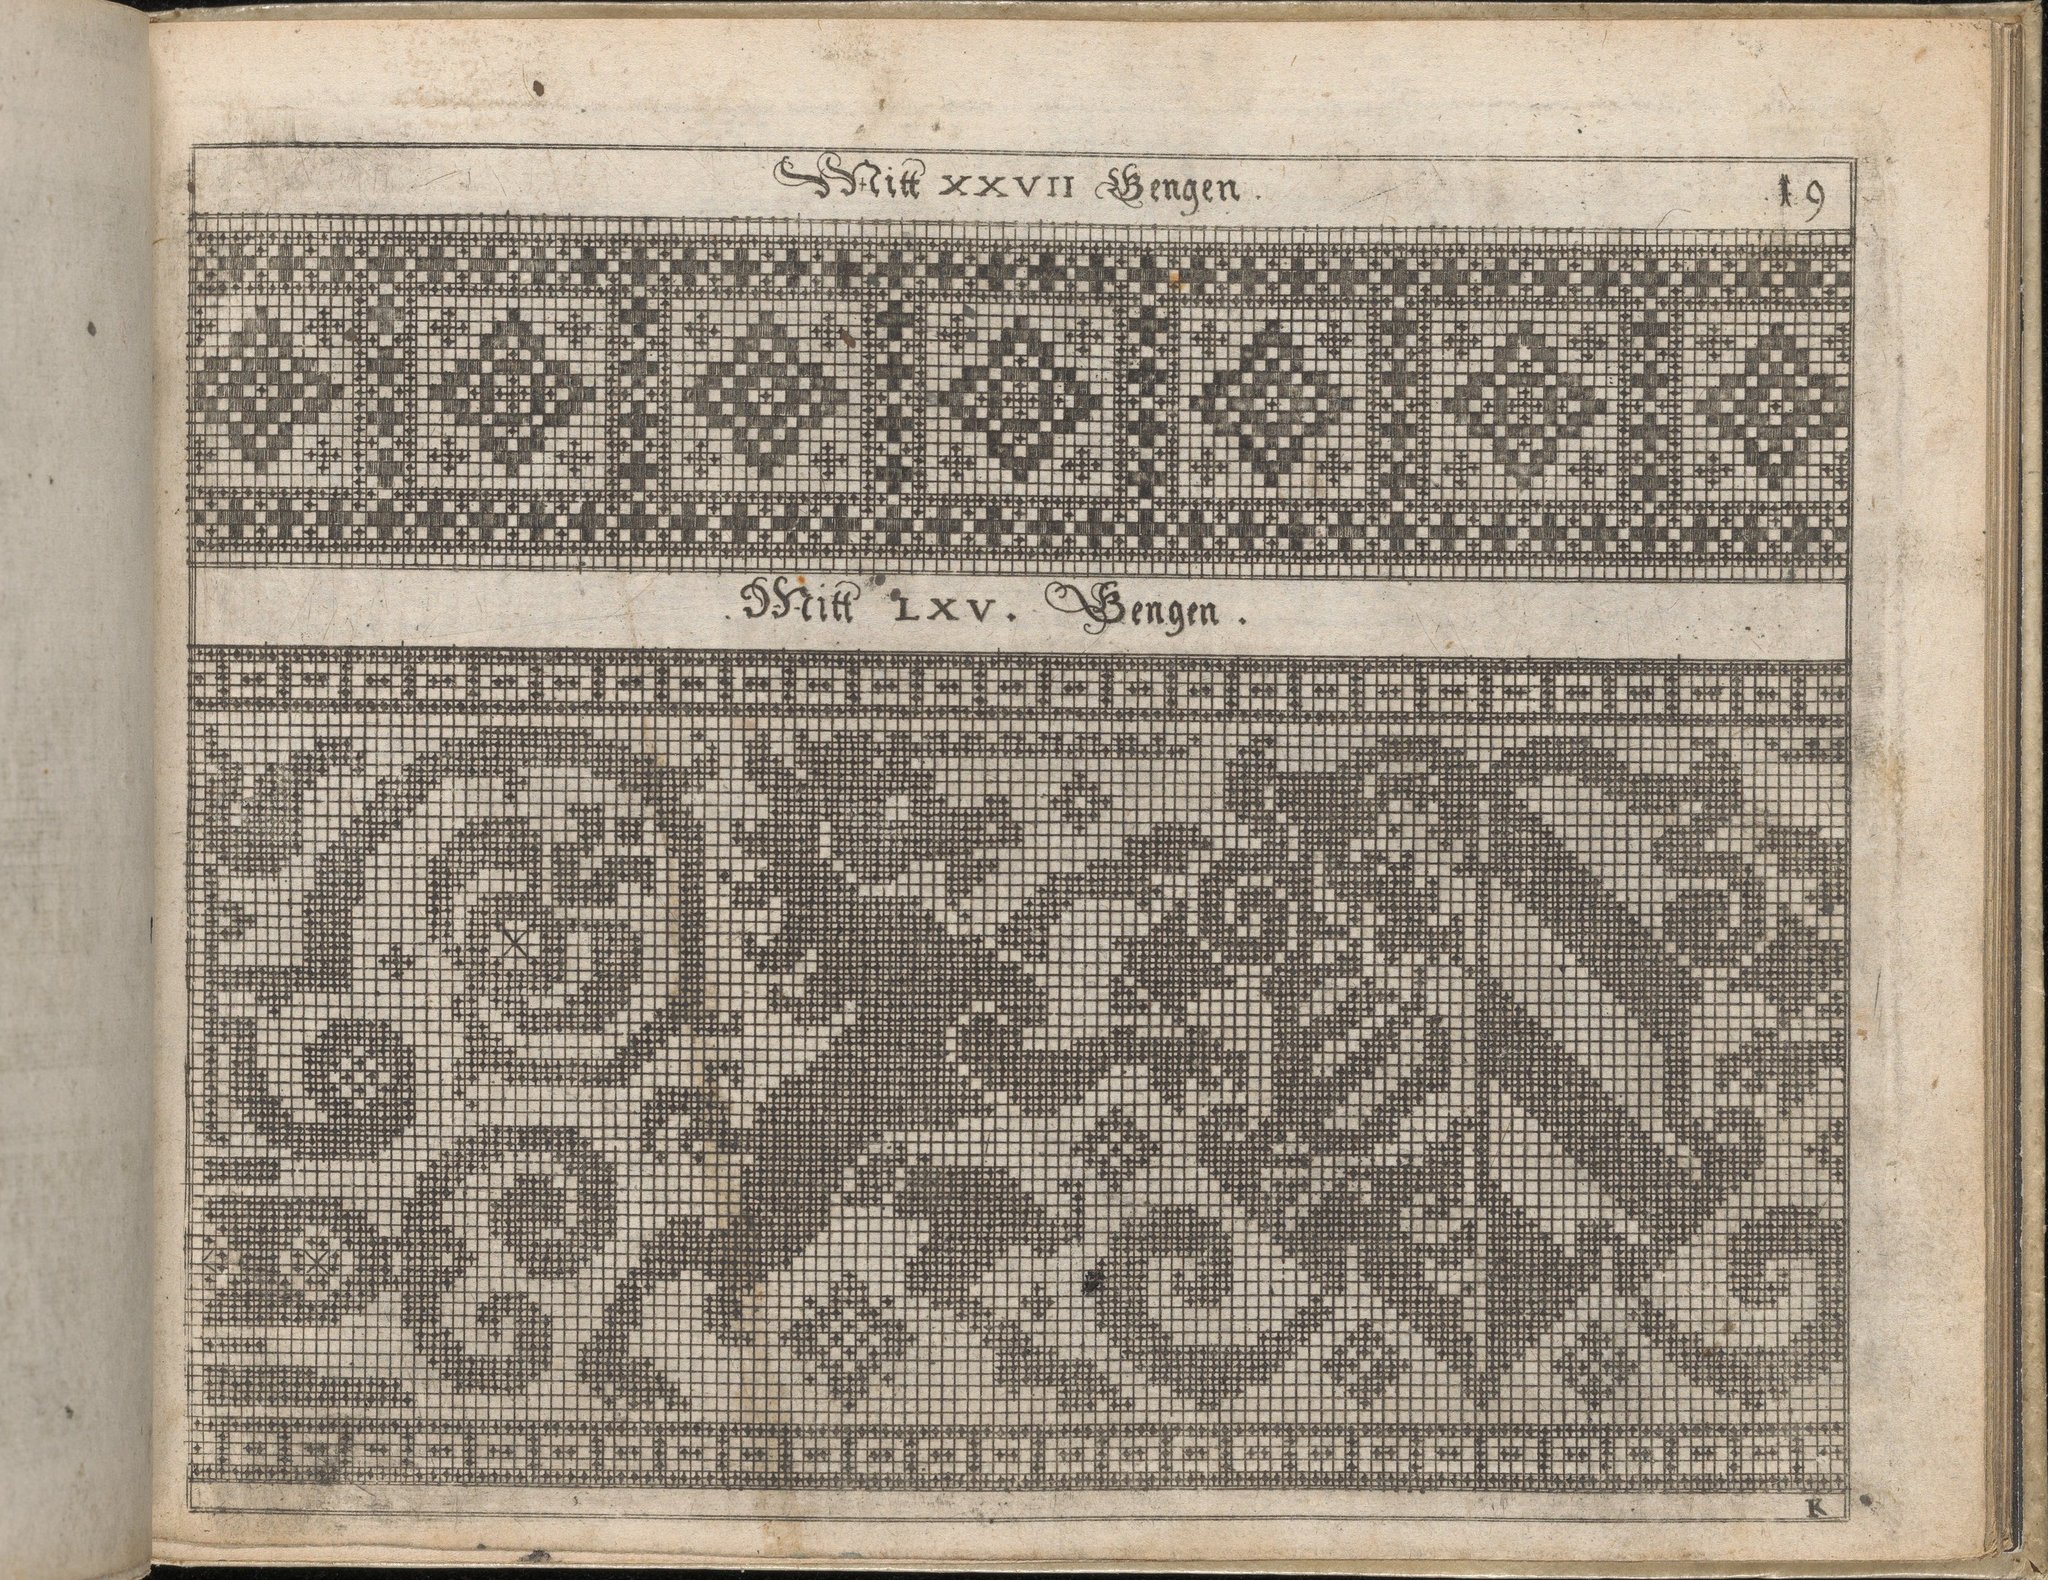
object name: book print ornament architecture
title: Newes Modelbuch in Kupffer (Page 28r)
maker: johann sibmacher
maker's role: artist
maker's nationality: german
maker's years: 1590-1611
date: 1604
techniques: etching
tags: ornament,horses